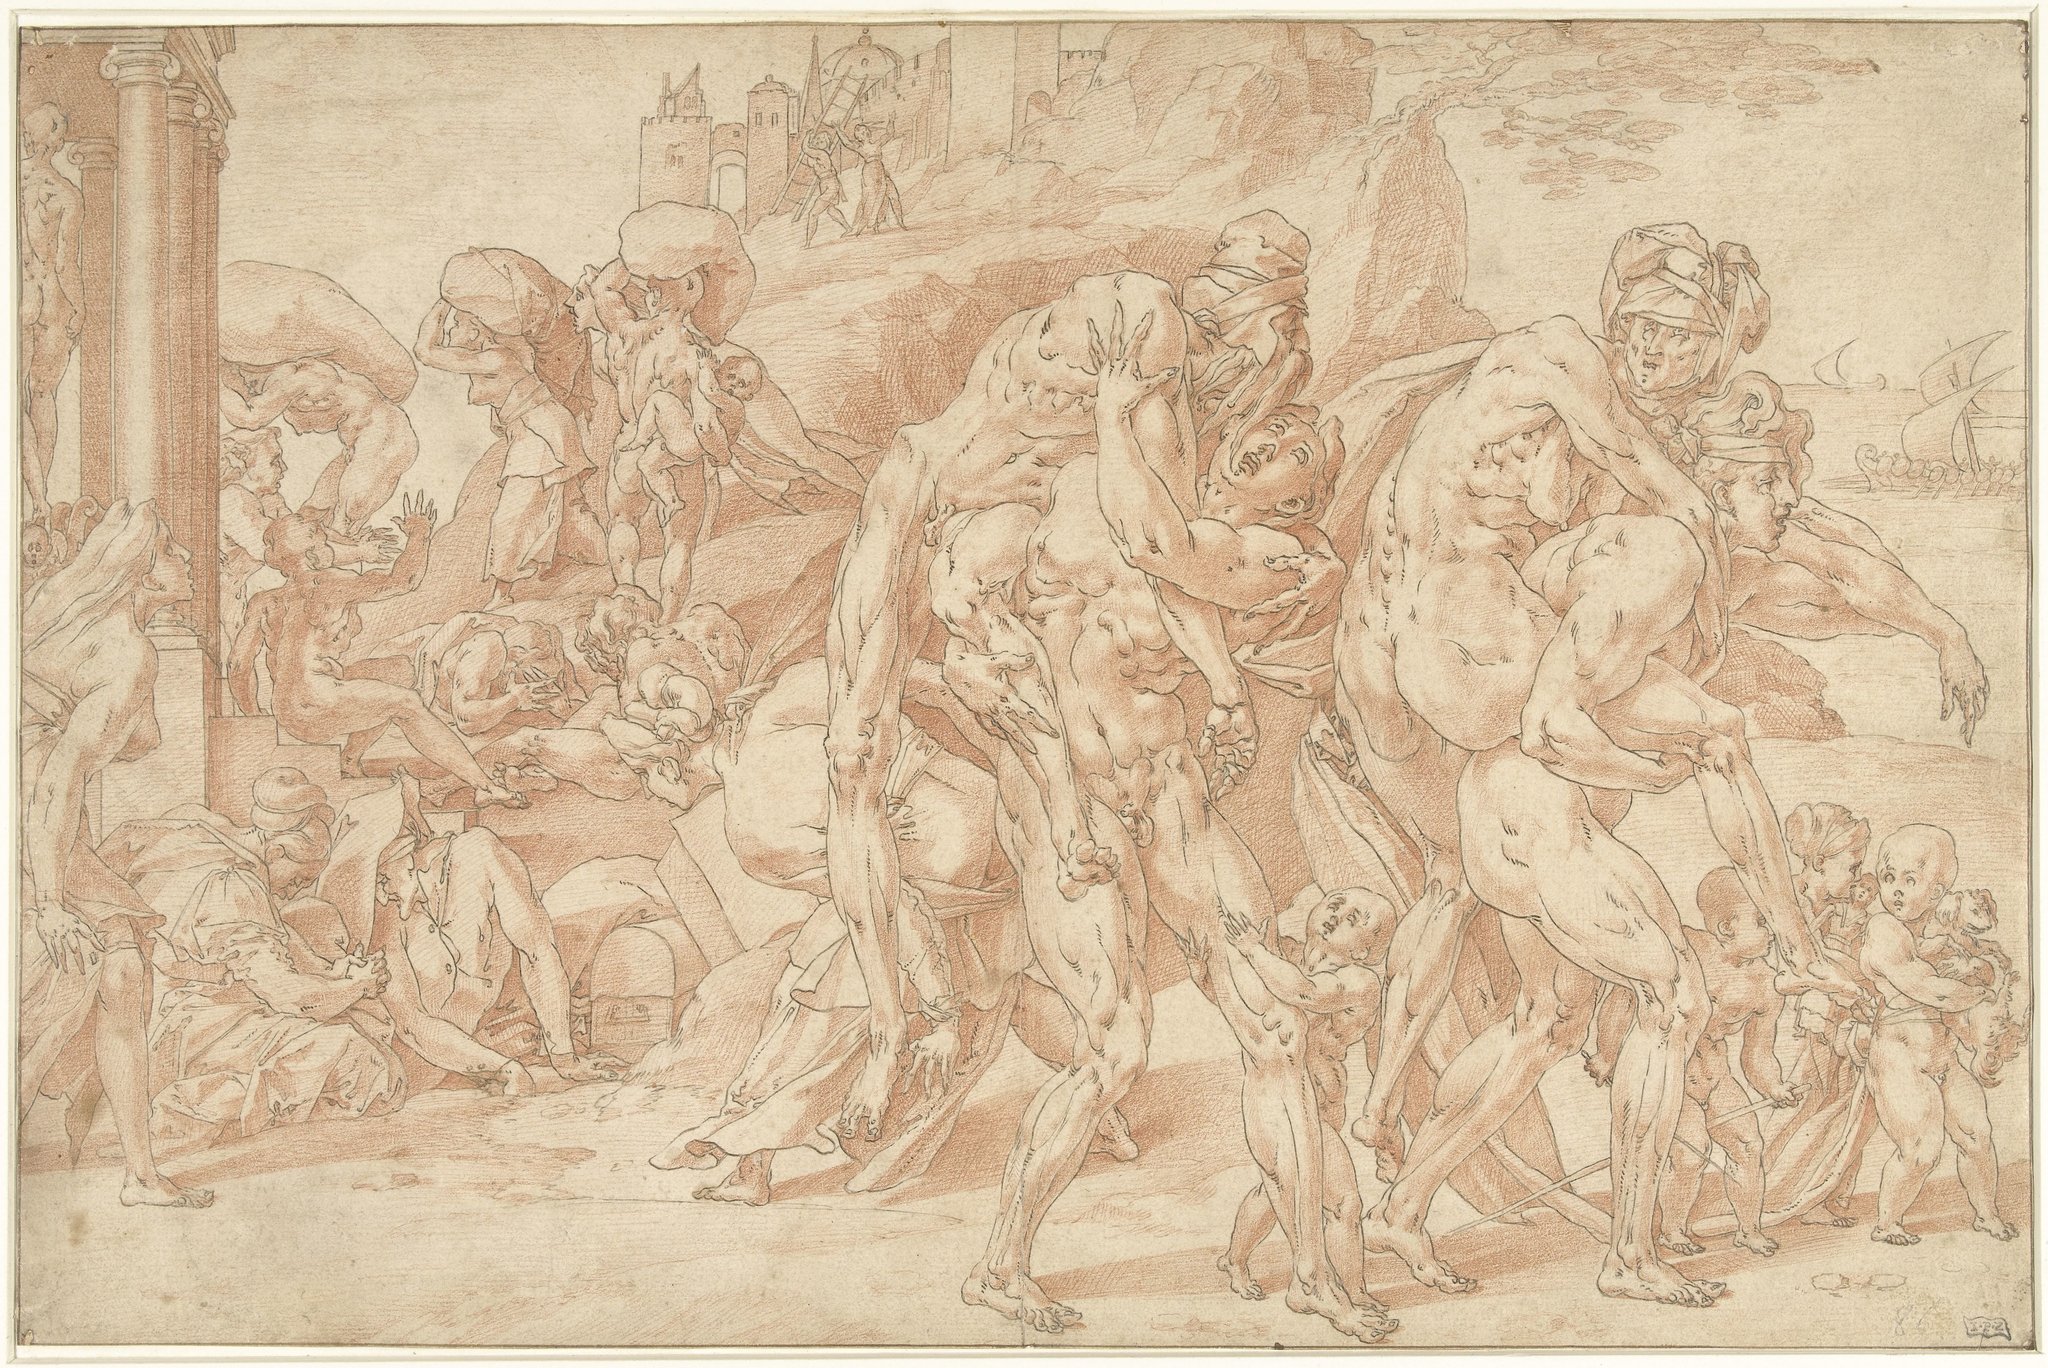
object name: drawing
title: Gevolgen van de eerbied van de kinderen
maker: Anonymous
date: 1535-1620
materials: chalk, ink, paper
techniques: pen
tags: on fire, ablaze, carrying a person, (story of) amphinomus and anapias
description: Het schilderij door Fiorentino bevond zich in de galerie François I, Fontainebleau, ca. 1535-1540.